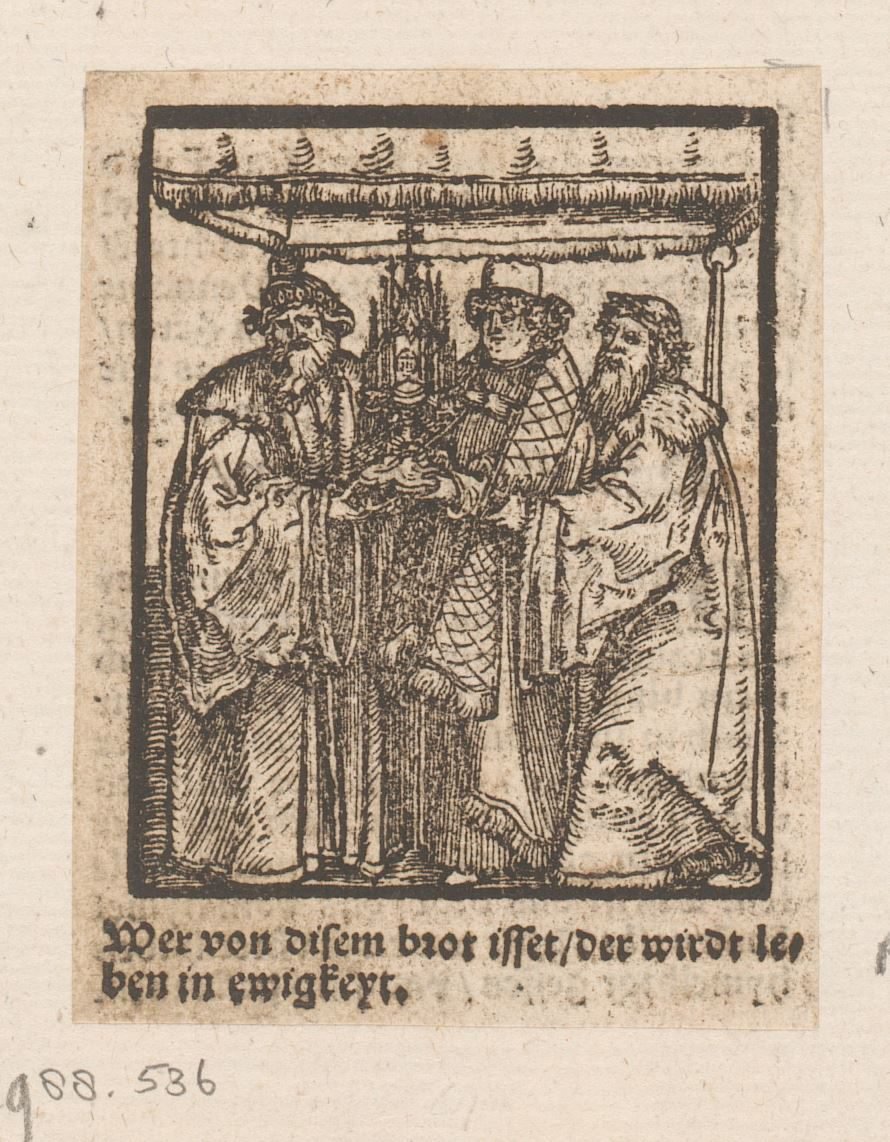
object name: book illustration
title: Corpus Christi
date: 1536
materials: paper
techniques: woodcut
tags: feast of corpus christi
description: Prent afkomstig uit: Evangelia und Epistel. Neurenberg: Hans Guldenmund, 1536.